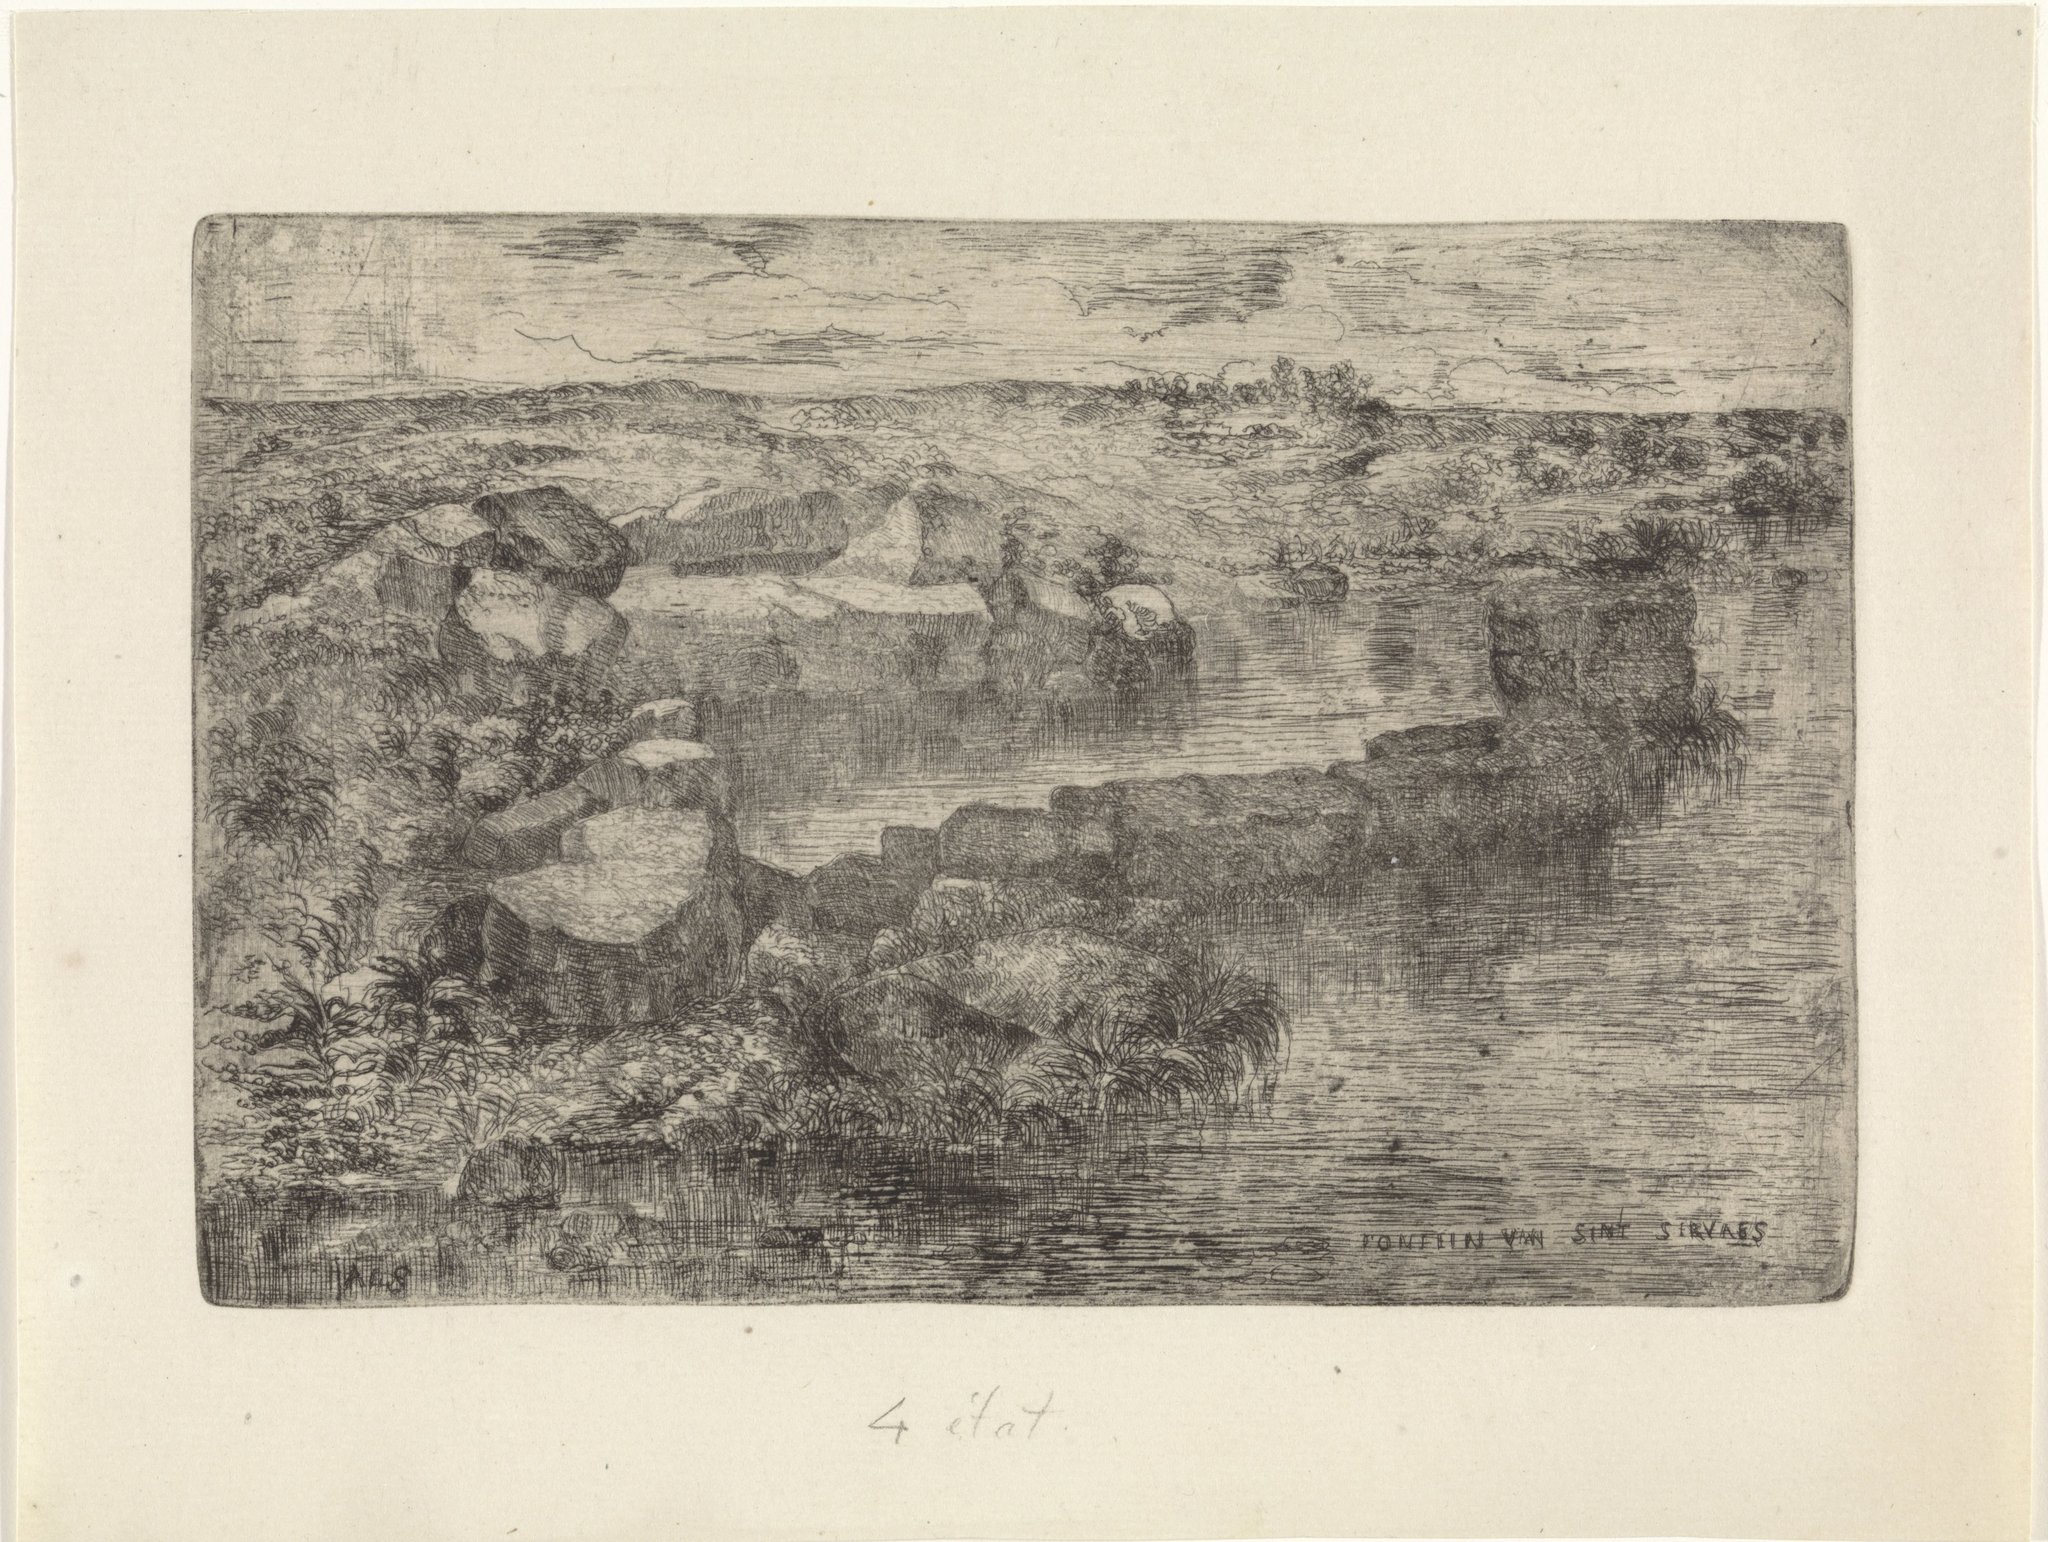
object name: print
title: Fontein van St. Servaes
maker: alexander schaepkens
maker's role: draughtsman, print maker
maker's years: 1815-1899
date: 1830-1899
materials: paper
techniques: etching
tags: landscapes with waters, waterscapes, seascapes (in the temperate zone), maastricht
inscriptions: collector's mark: Lugt 2228